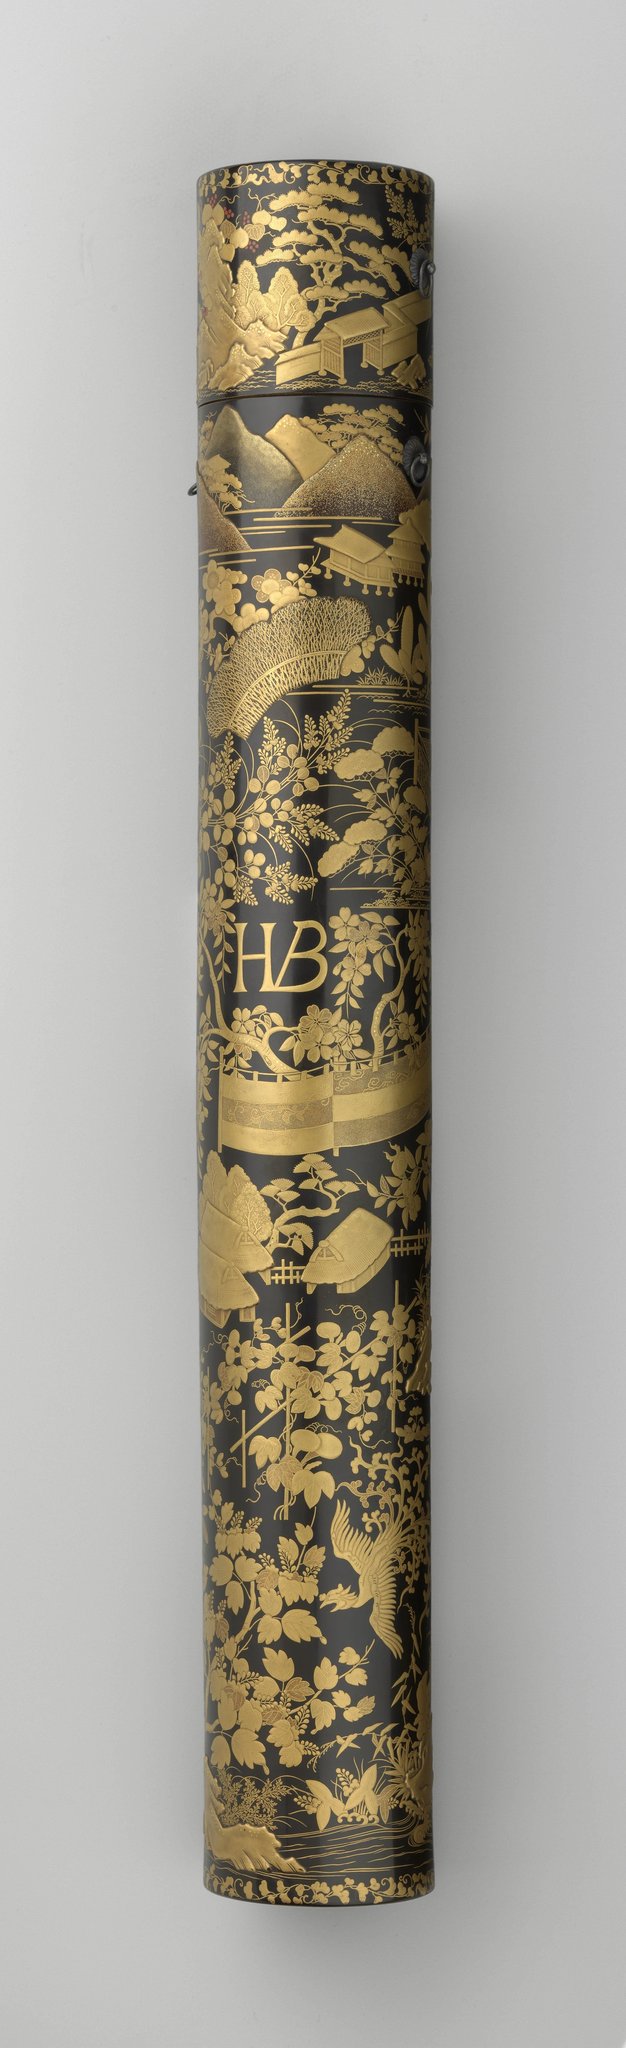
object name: documentkoker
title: Documentenkoker van Japans lakwerk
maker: Anonymous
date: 1684-1692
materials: lacquer, wood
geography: japan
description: Koker van zwarte lak met decoraties van bloeienden planten bij rotsen en heggen in goudlak en enkele malen de initialen HB voor Hendrick van Buijtenhem. Daarin vier documenten (AK-C-2012-28-2 tm -5).